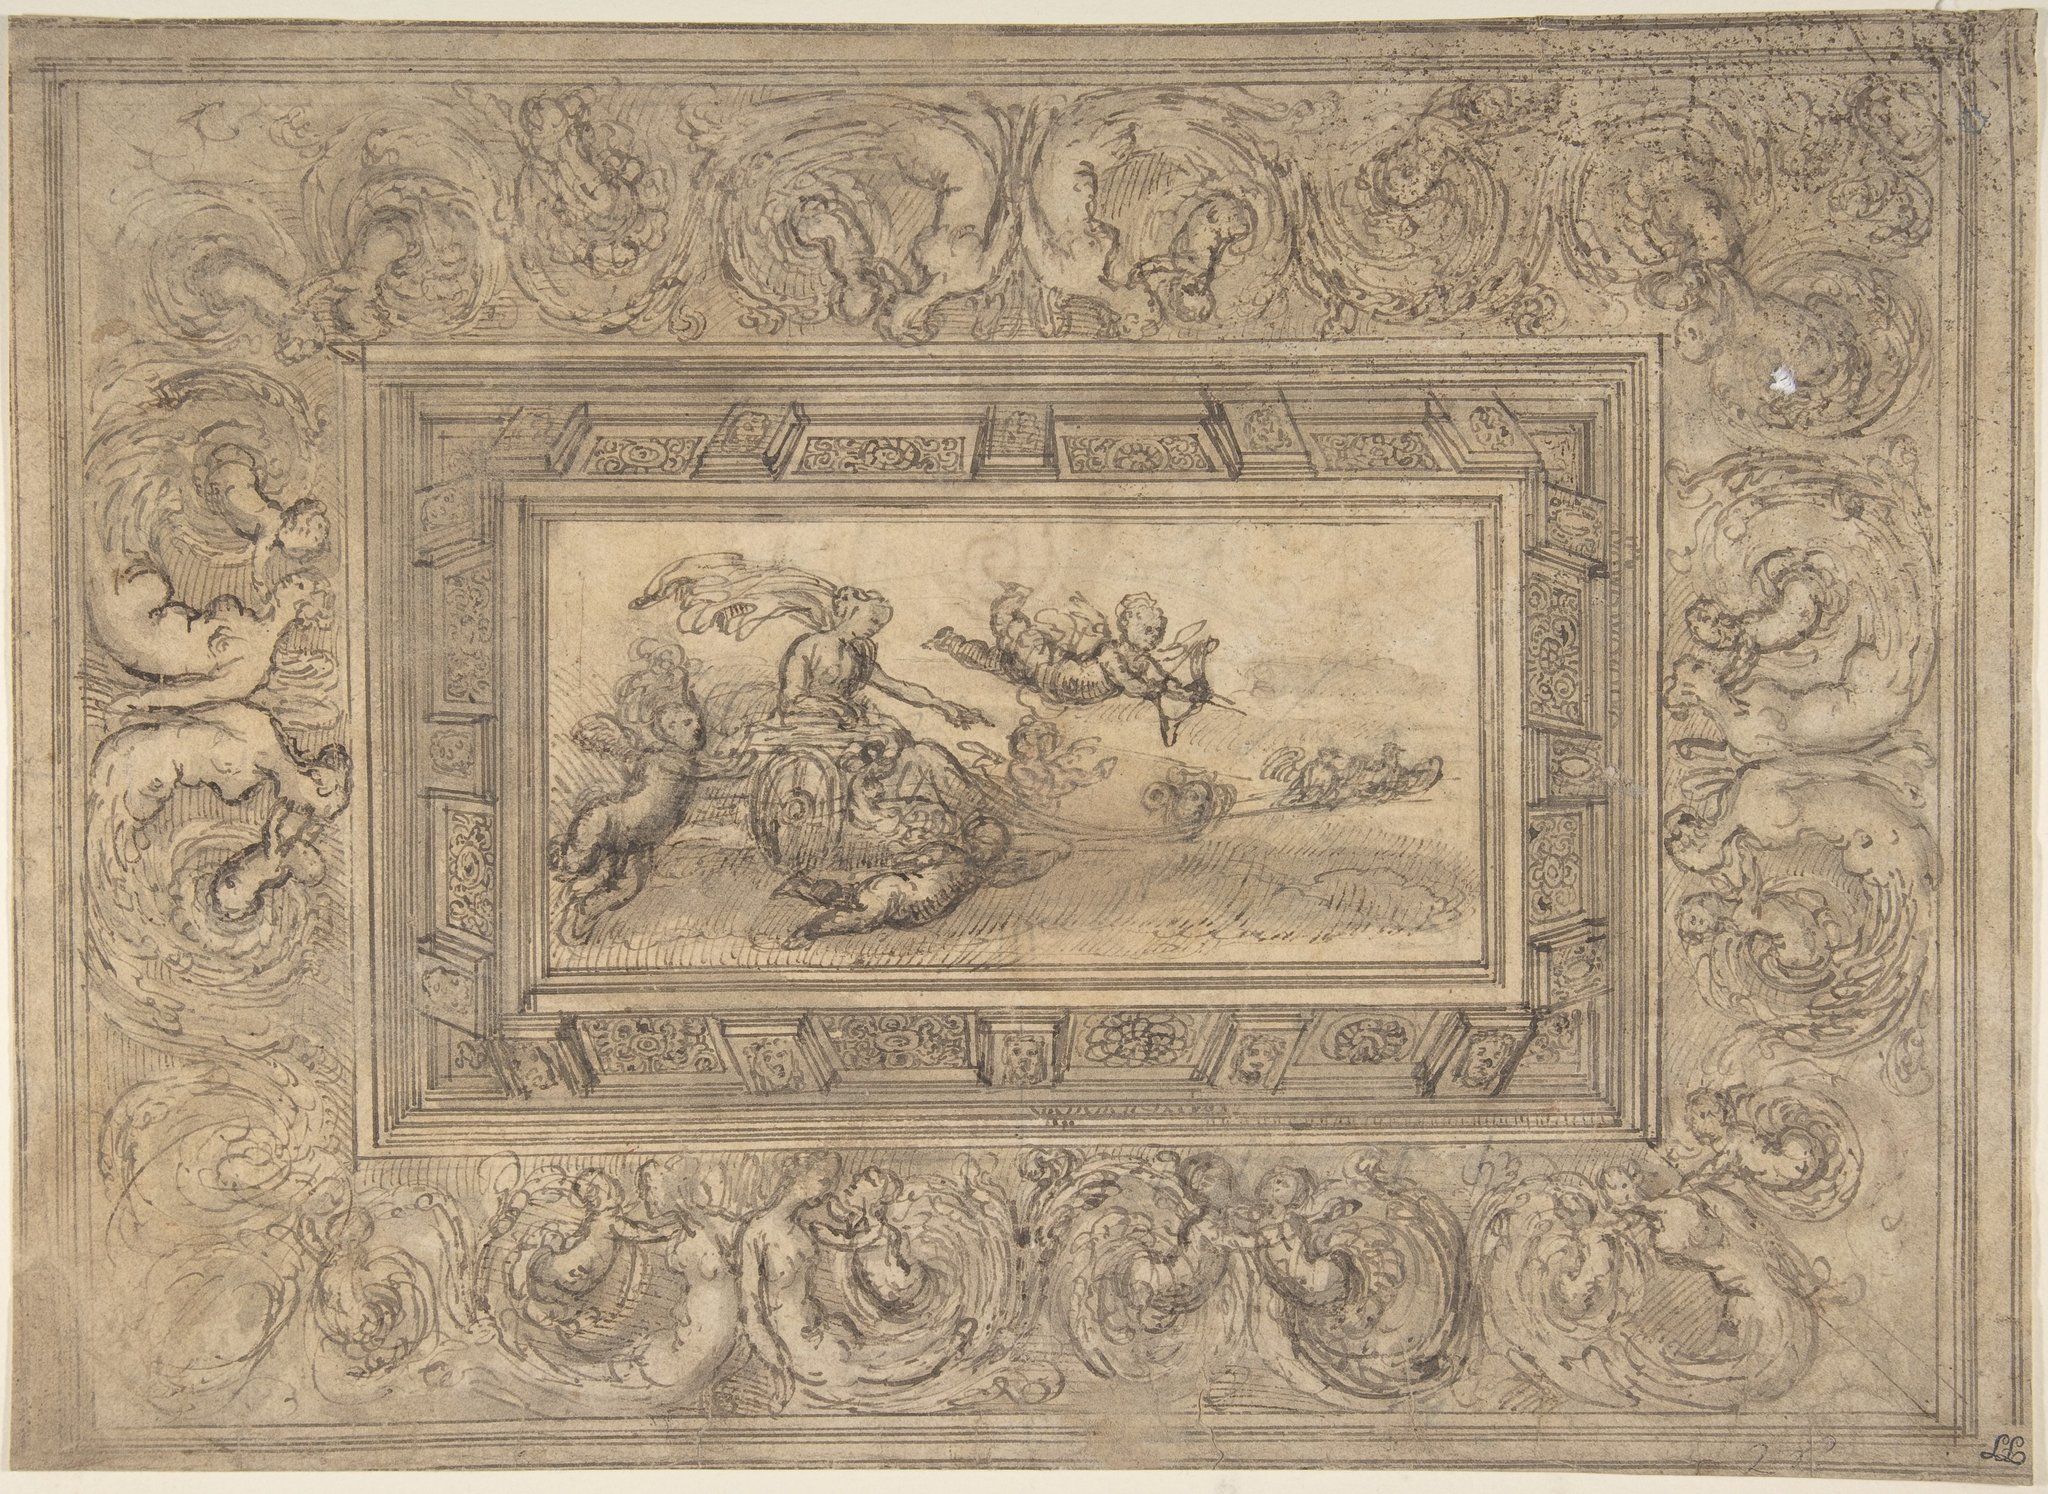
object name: drawing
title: Design for a Ceiling with a Woman (Aurora?) in a Chariot and Putti (Recto). Design for an Ornamental Frieze (Verso).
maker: marco angolo del moro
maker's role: artist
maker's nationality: italian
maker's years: 1537-1586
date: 1537-1586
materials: chalk, graphite, ink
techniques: brush, pen, wash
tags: women,putti,chariots